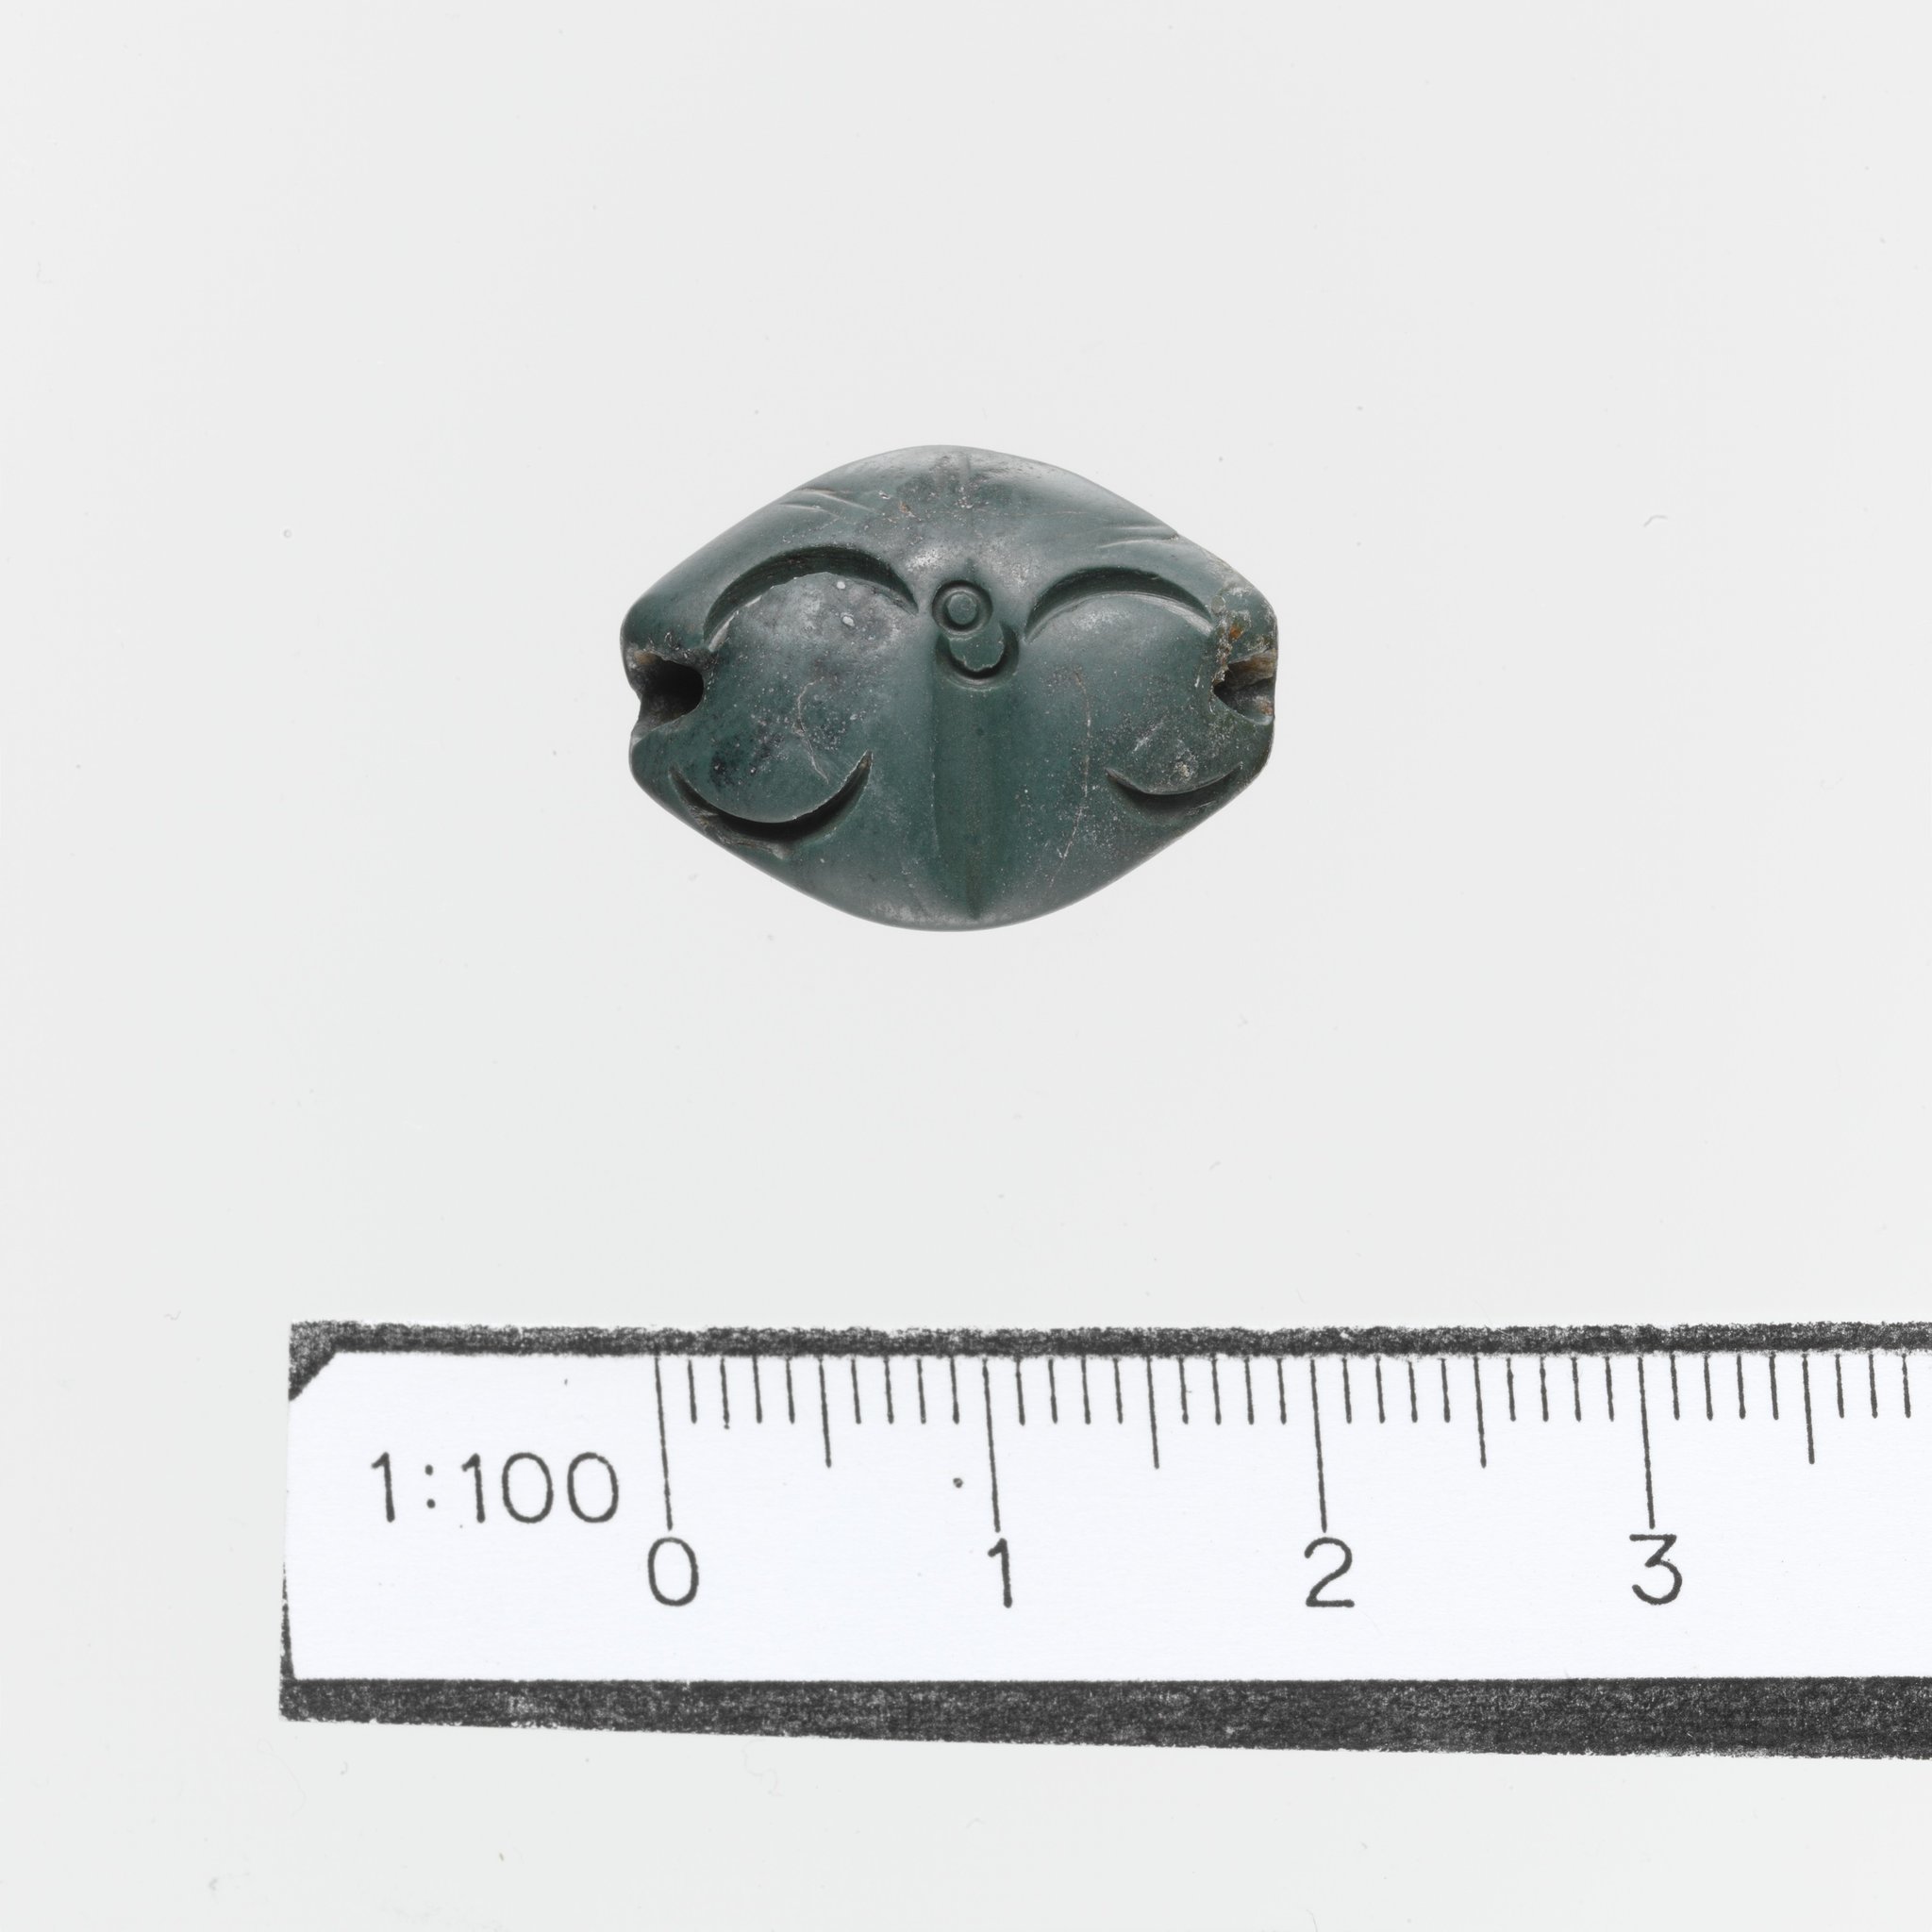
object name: seal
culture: minoan, crete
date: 2000-1450 BCE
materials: jasper